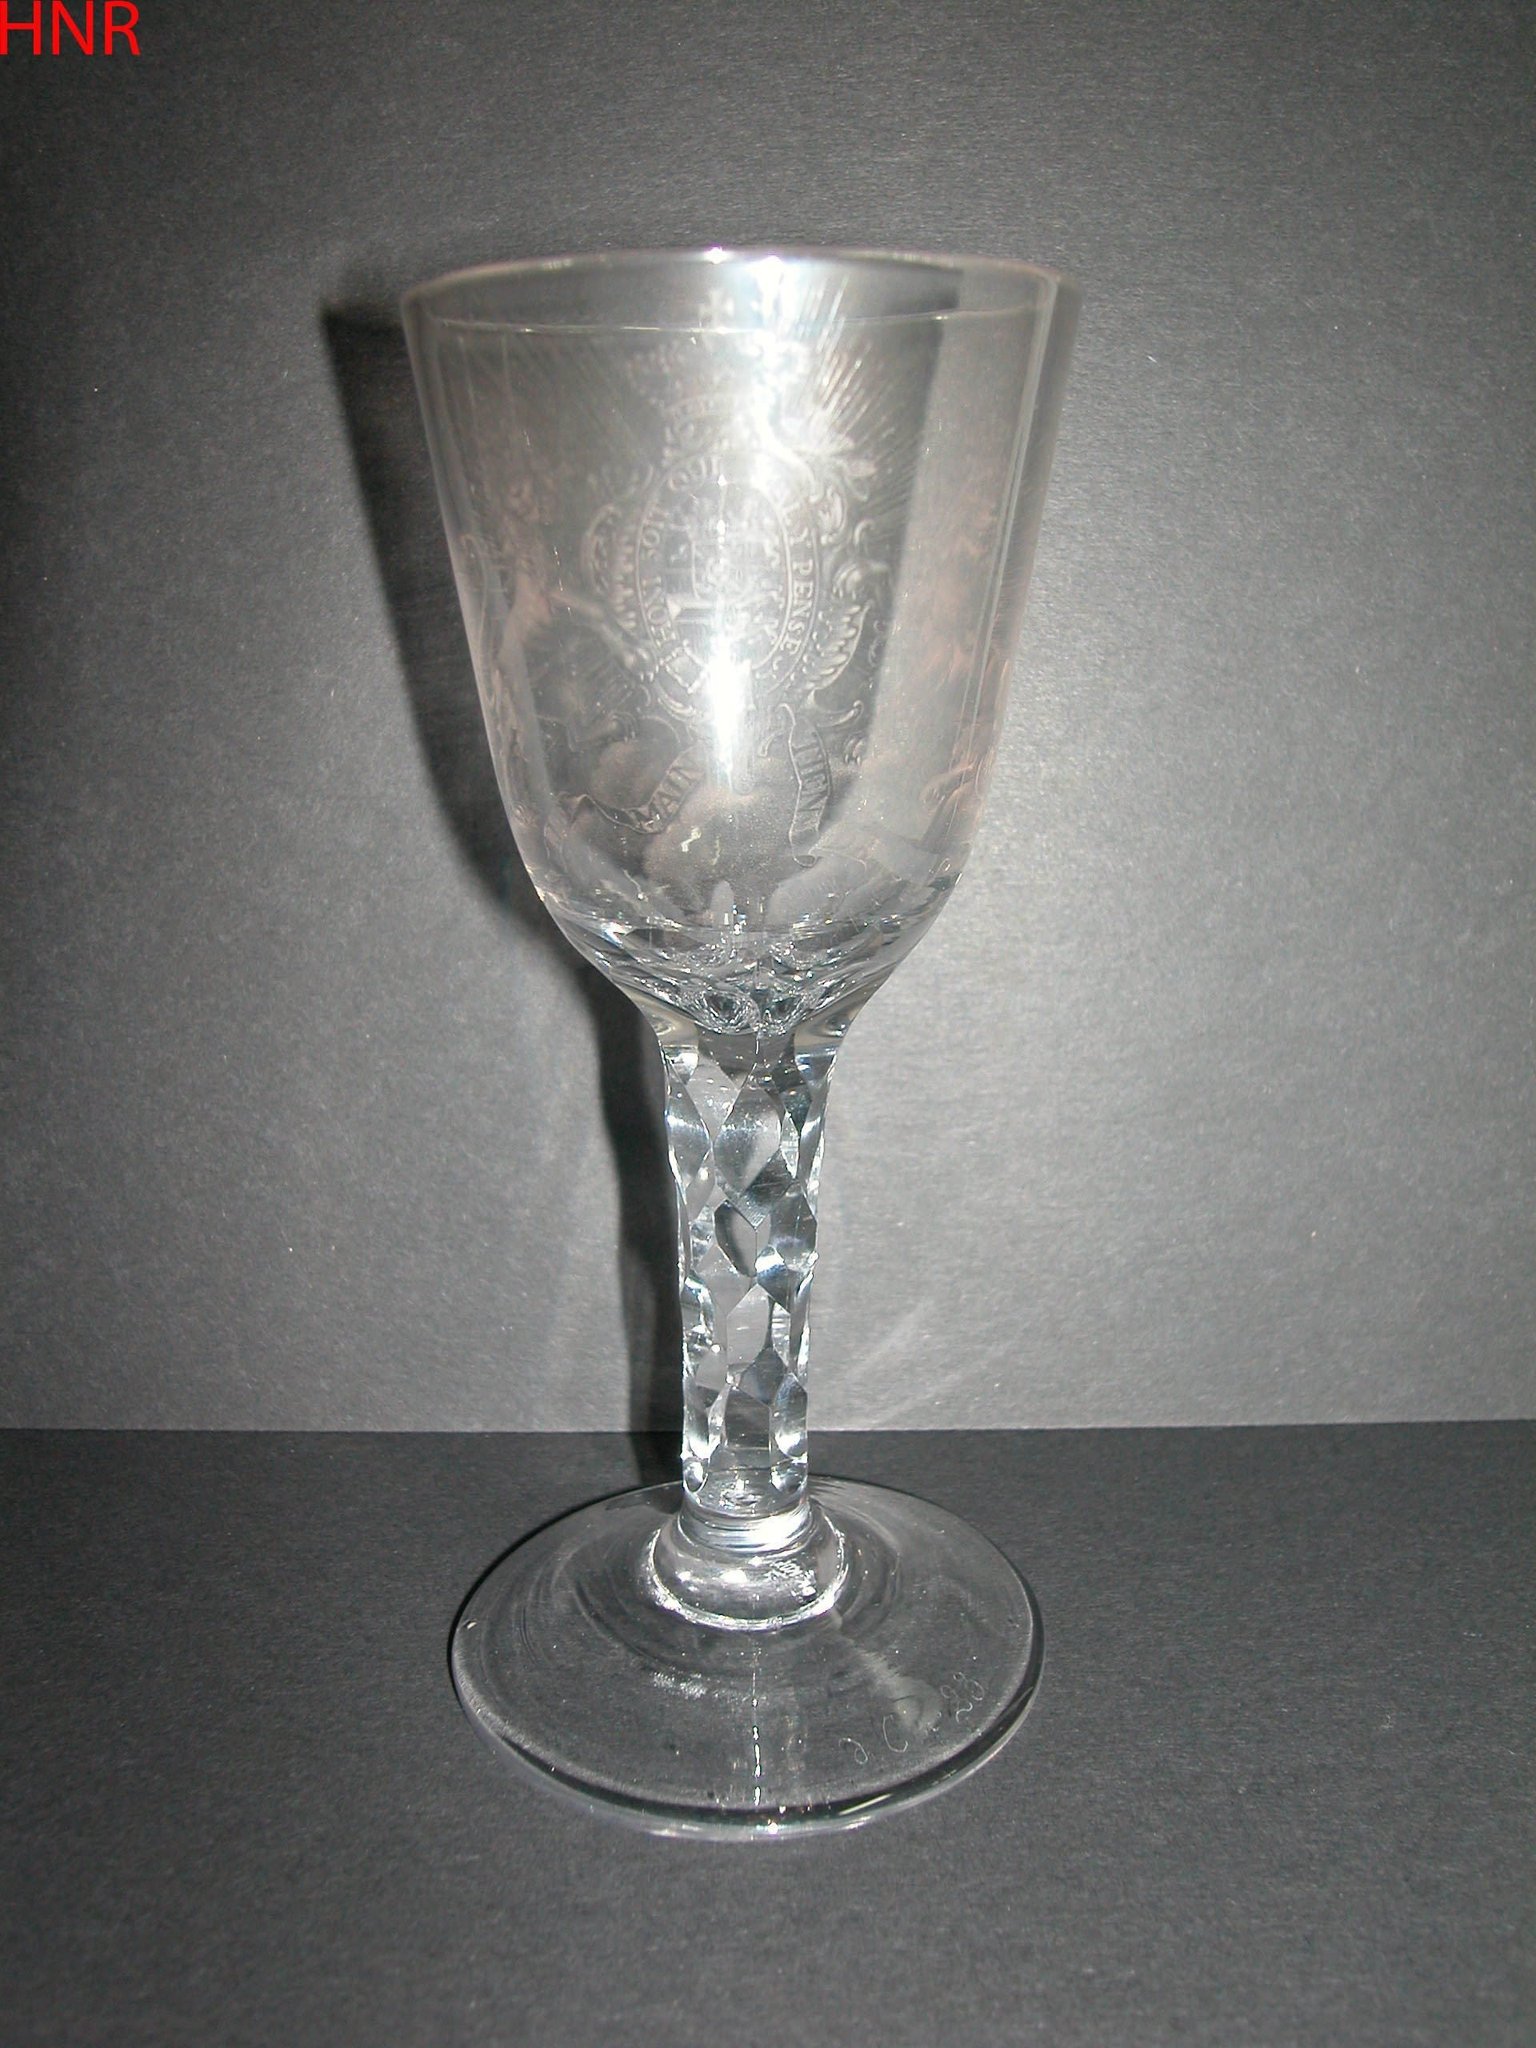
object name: goblet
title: Kelkglas met het wapen van Willem V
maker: meester alius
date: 1760-1780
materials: glass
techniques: glassblowing, grinding, engraving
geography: the hague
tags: the hague, william v (prince of orange)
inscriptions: inscription, inscription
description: Conische voet. Zich verbredende , facetgeslepen stam, overgaande in een gebogen kelk. Op de kelk, in een stralenkrans, het wapen van stadhouder prins Willem V met de Kouseband en de tekst: HONI SOIT QUI MAL Y PENSE. Als schilddragers twee gekroonde leeuwen. Onder het wapen in een banderolle de tekst: JE MAIN TIEN DRAY.